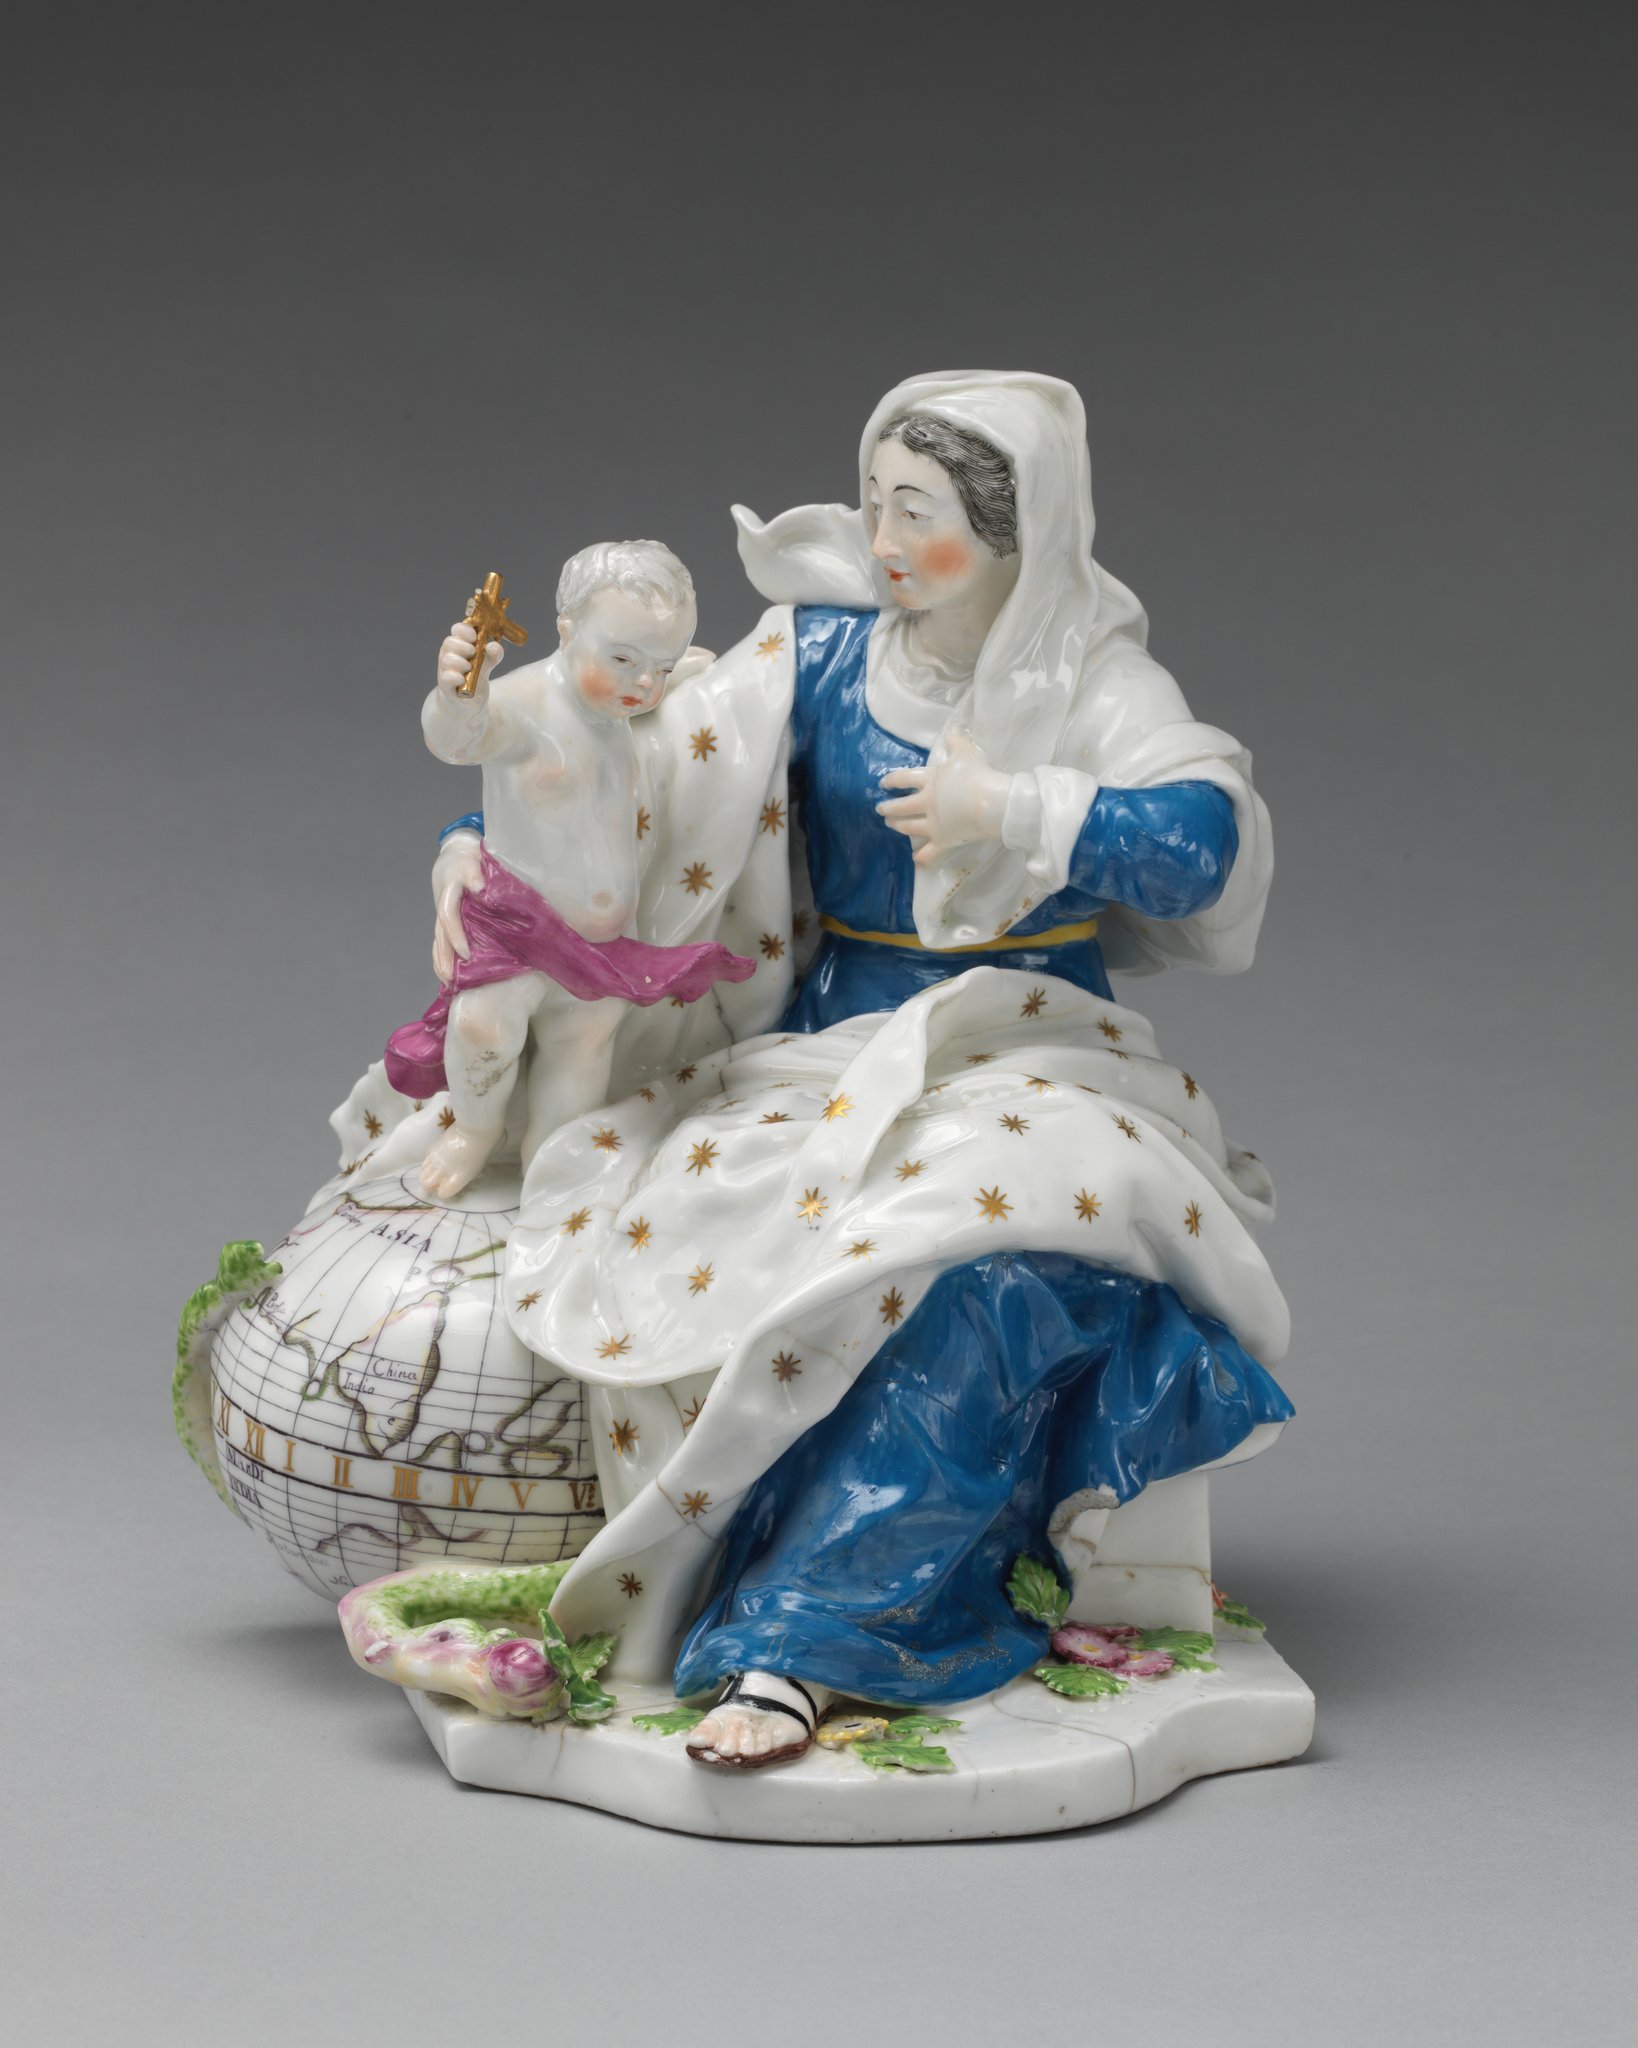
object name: group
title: Virgin and Child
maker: chelsea porcelain manufactory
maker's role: factory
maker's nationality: british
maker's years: 1744-1784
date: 1755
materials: soft paste porcelain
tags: madonna and child,globes